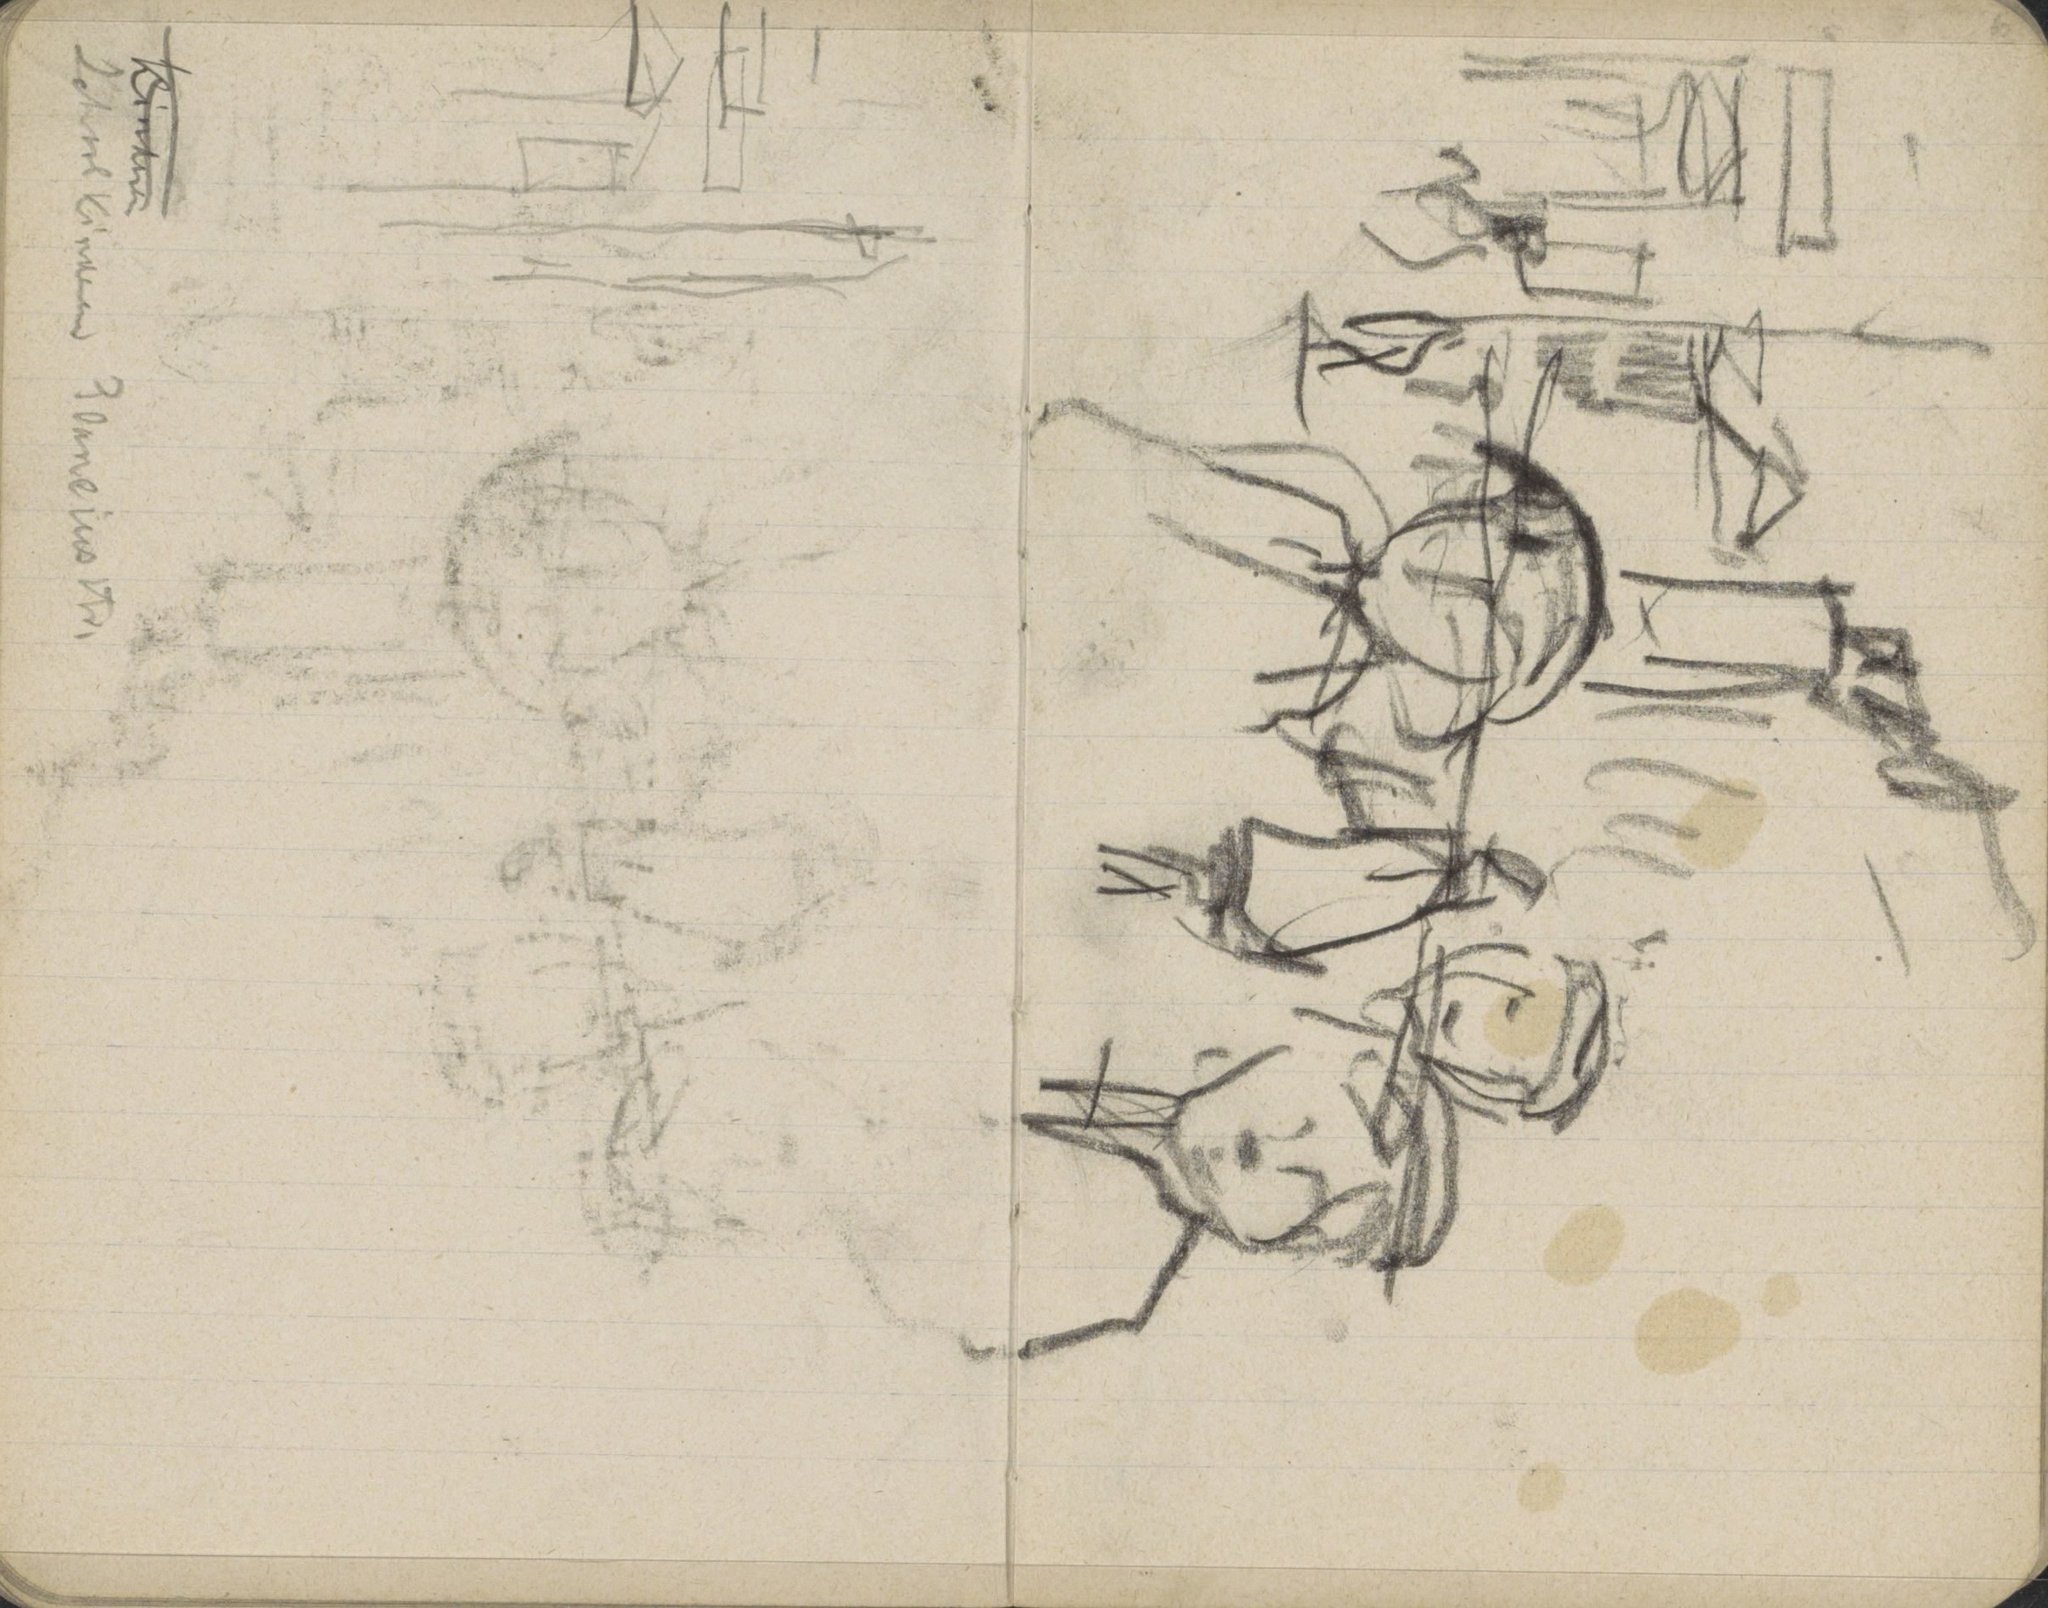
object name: sketchbook leaf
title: Schoolkinderen in de Planciusstraat te Amsterdam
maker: george hendrik breitner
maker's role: draughtsman, painter, print maker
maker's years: 1857-1923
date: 1903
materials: chalk, pencil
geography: amsterdam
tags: child, street (+ city(-scape) with figures, staffage)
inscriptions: annotation: ‘Schoolkinderen Planciusstr.’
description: Pagina 59 en pagina 60 uit een schetsboek met 32 bladen.